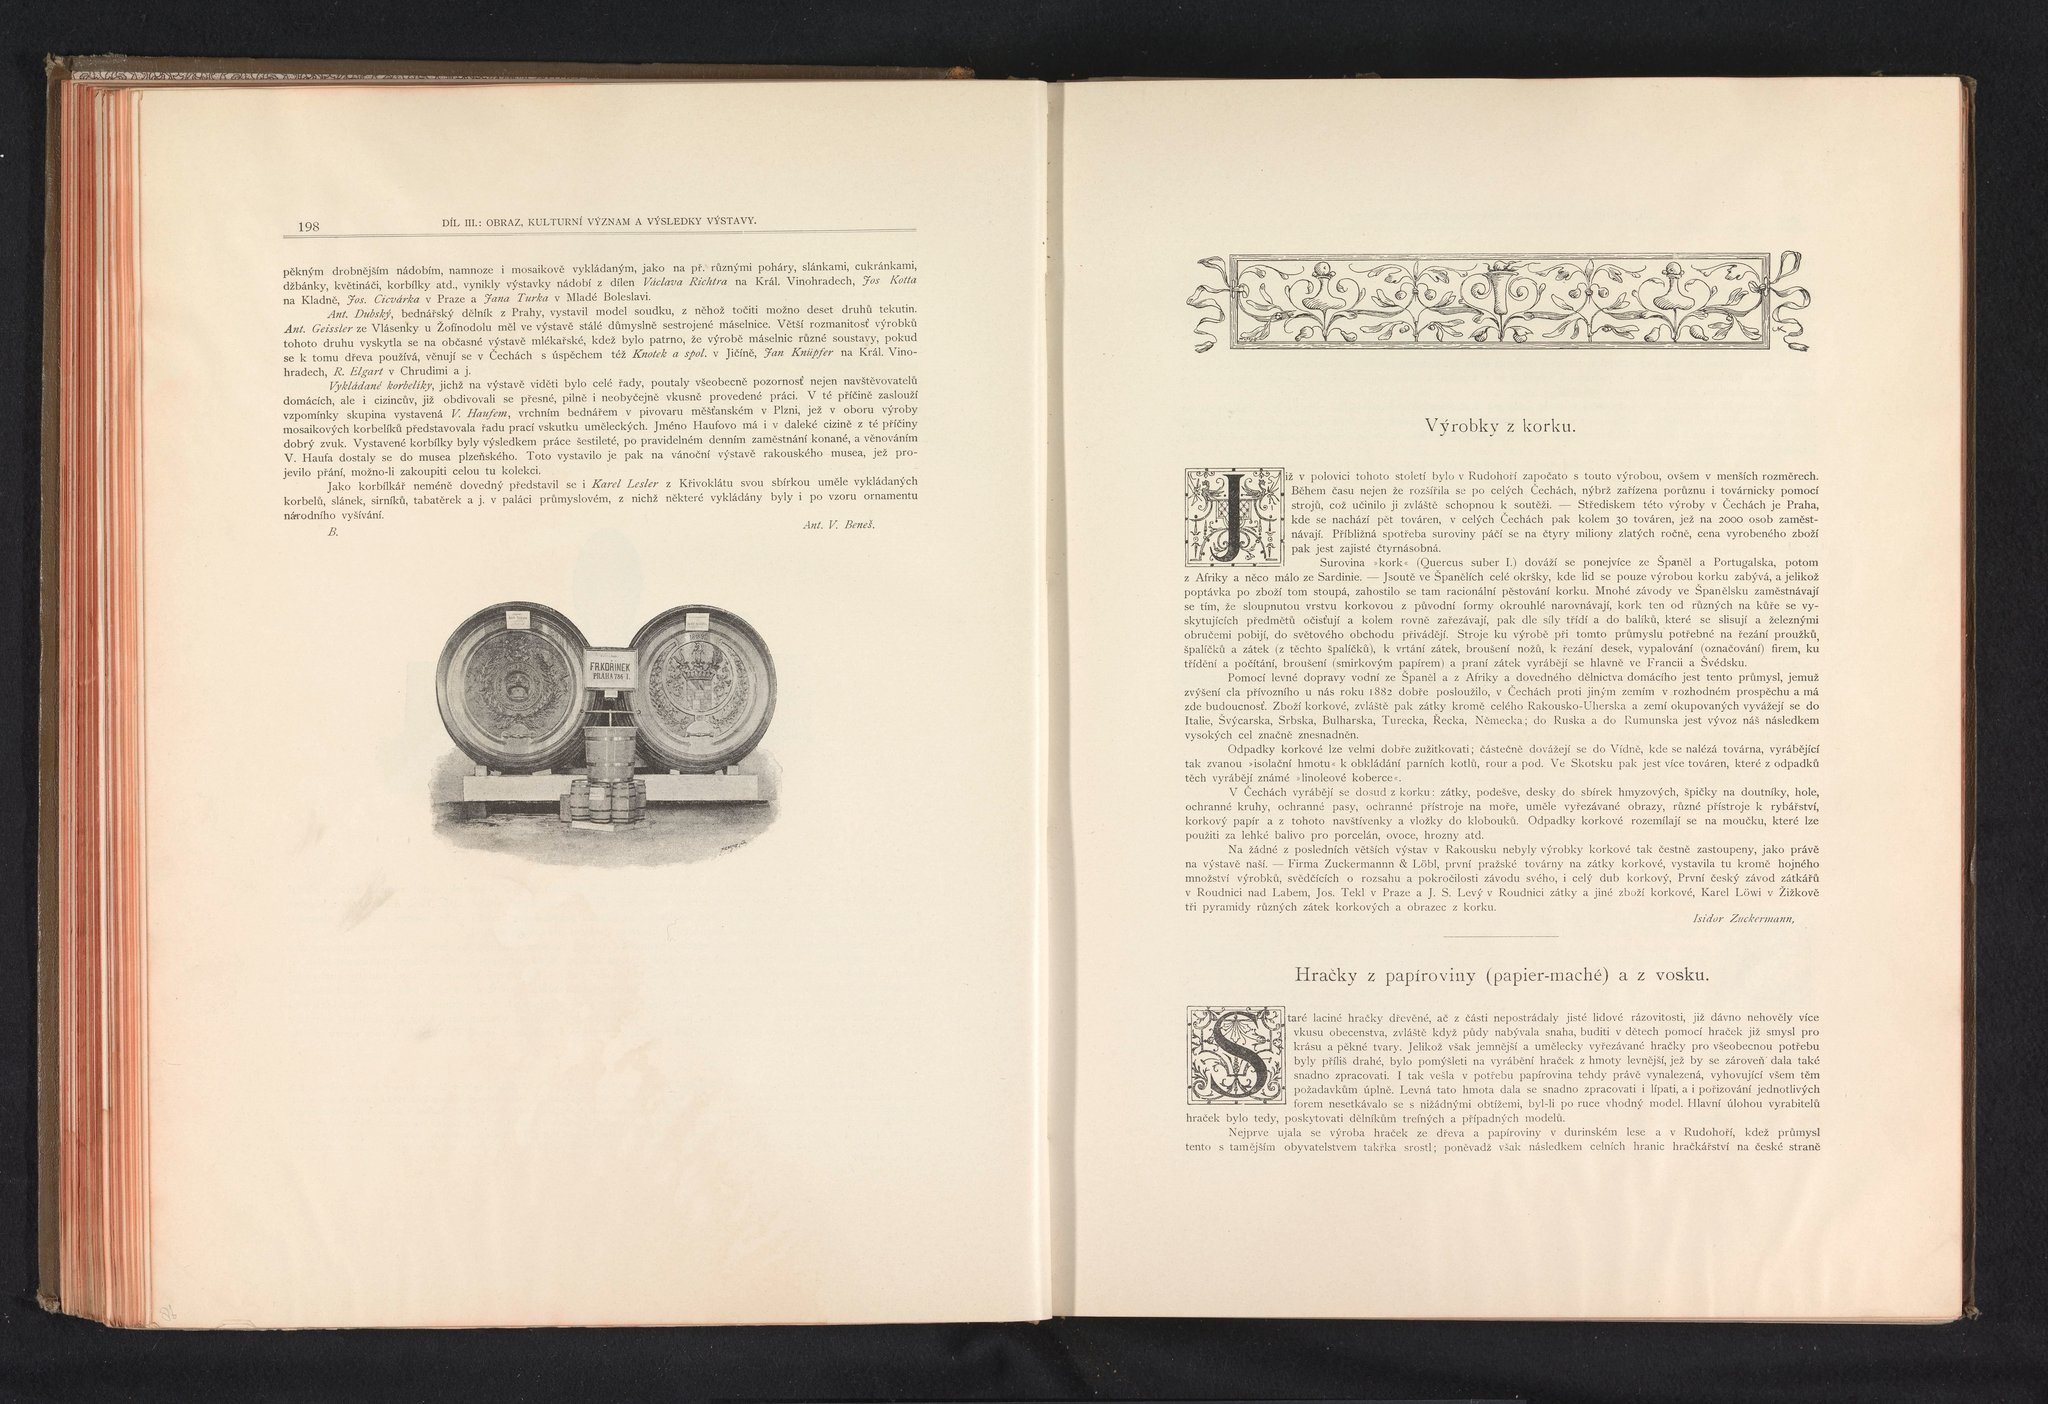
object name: photomechanical print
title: Uitstalling van houten vaten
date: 1890-1895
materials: paper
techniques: autotype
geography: prague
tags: wooden container: barrel, cask, bucket